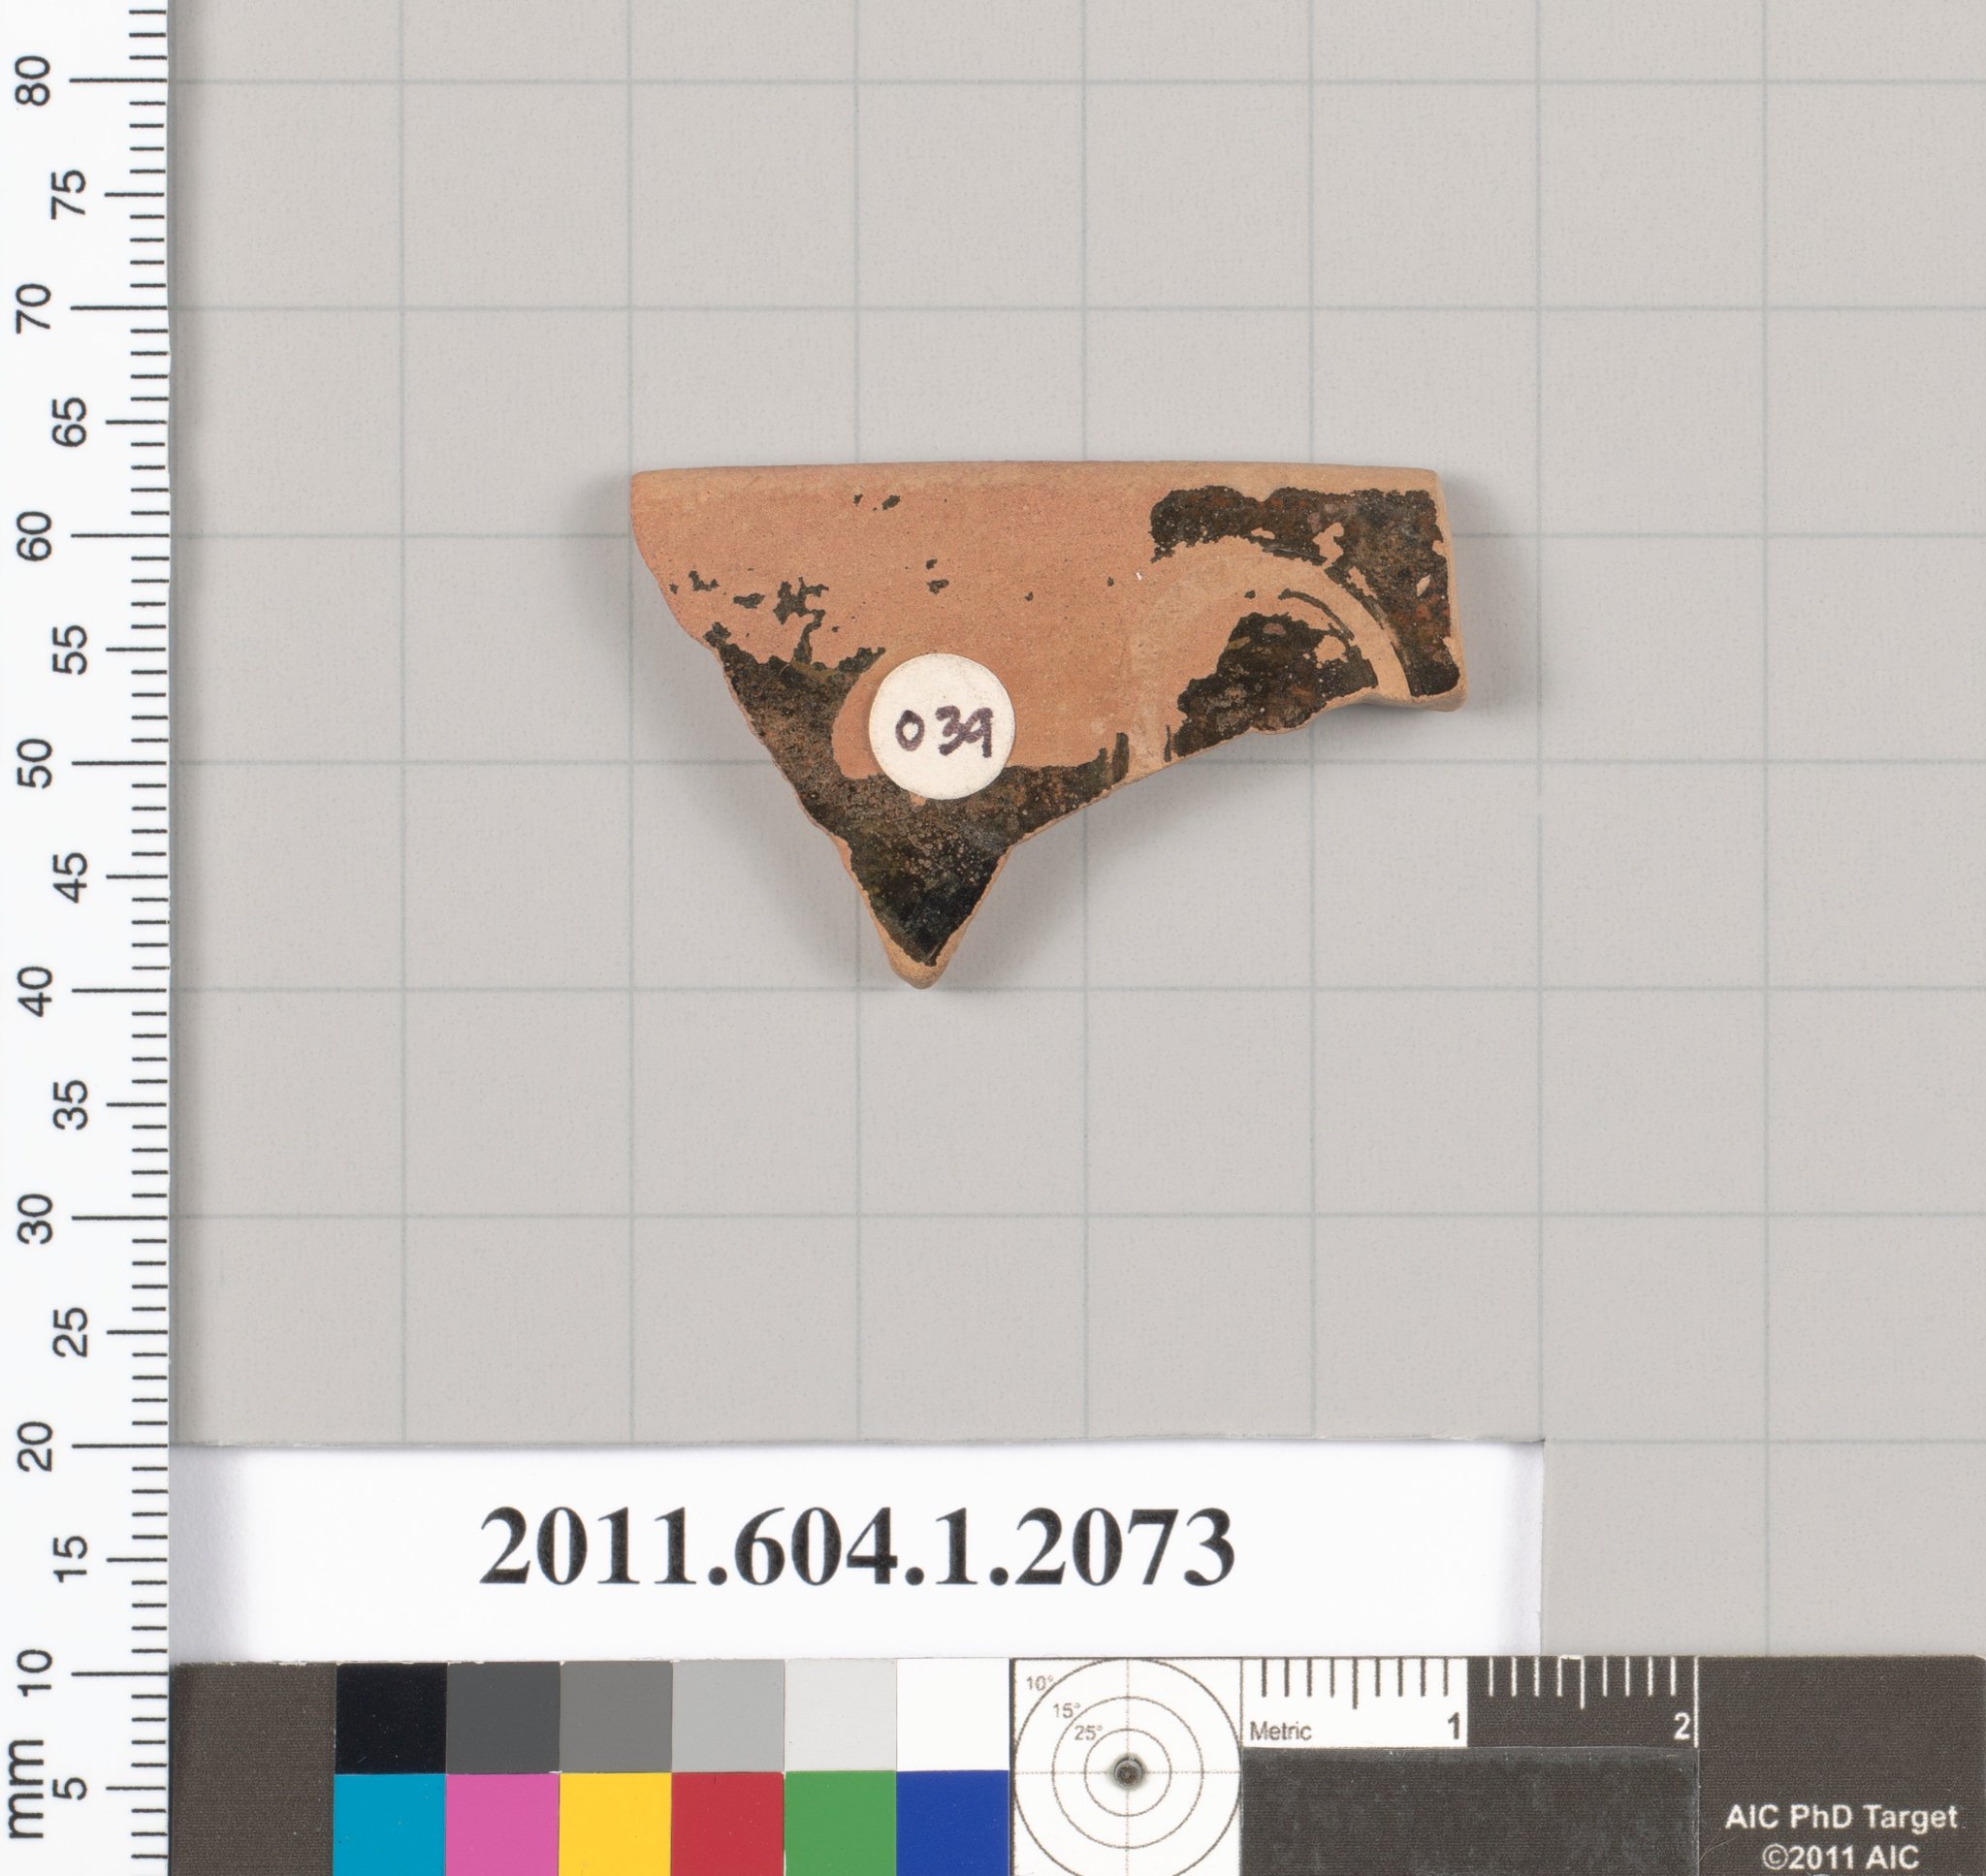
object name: kylix fragment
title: Terracotta rim fragment of a kylix (drinking cup)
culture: greek, attic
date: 475-451 BCE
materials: terracotta